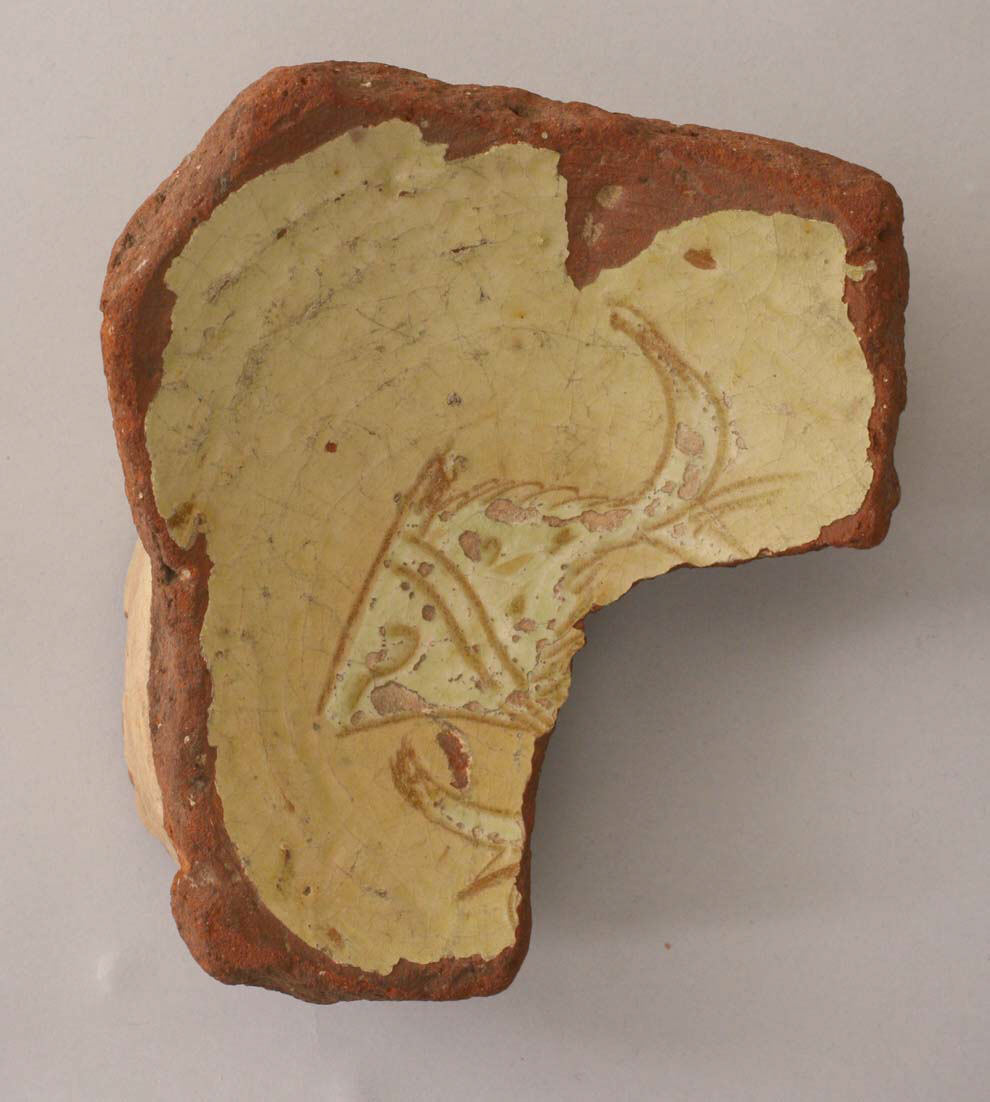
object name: fragment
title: Fragment of a Bowl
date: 1301-1500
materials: earthenware, glaze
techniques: coloring, incising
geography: egypt